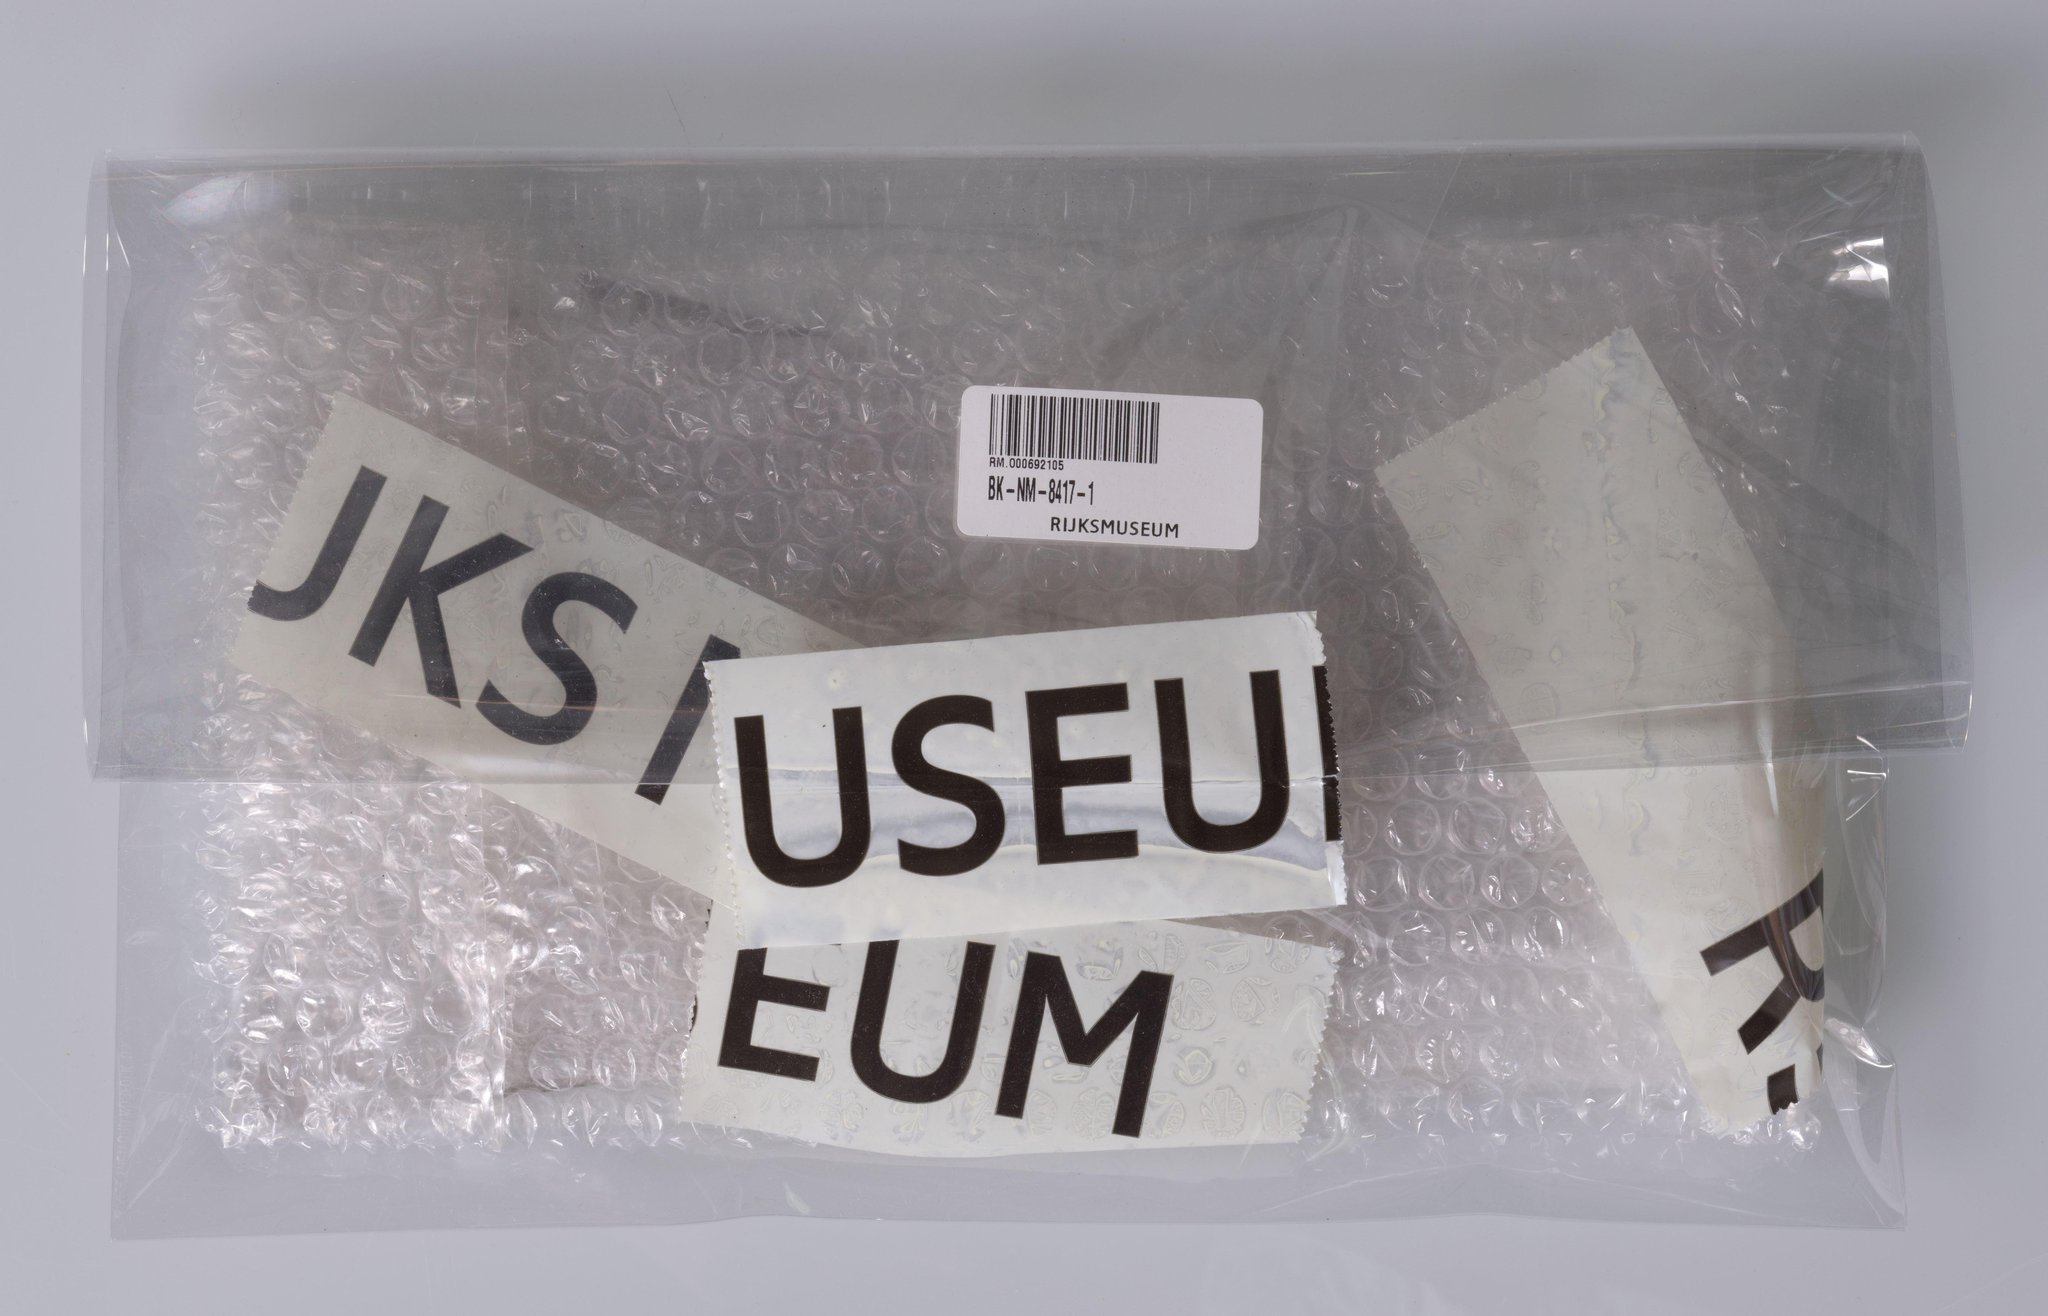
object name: lantern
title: Glas van lantaarn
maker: Anonymous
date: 1700-1715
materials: glass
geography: northern netherlands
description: Eén glasplaat (venster) en vijf fragmenten.